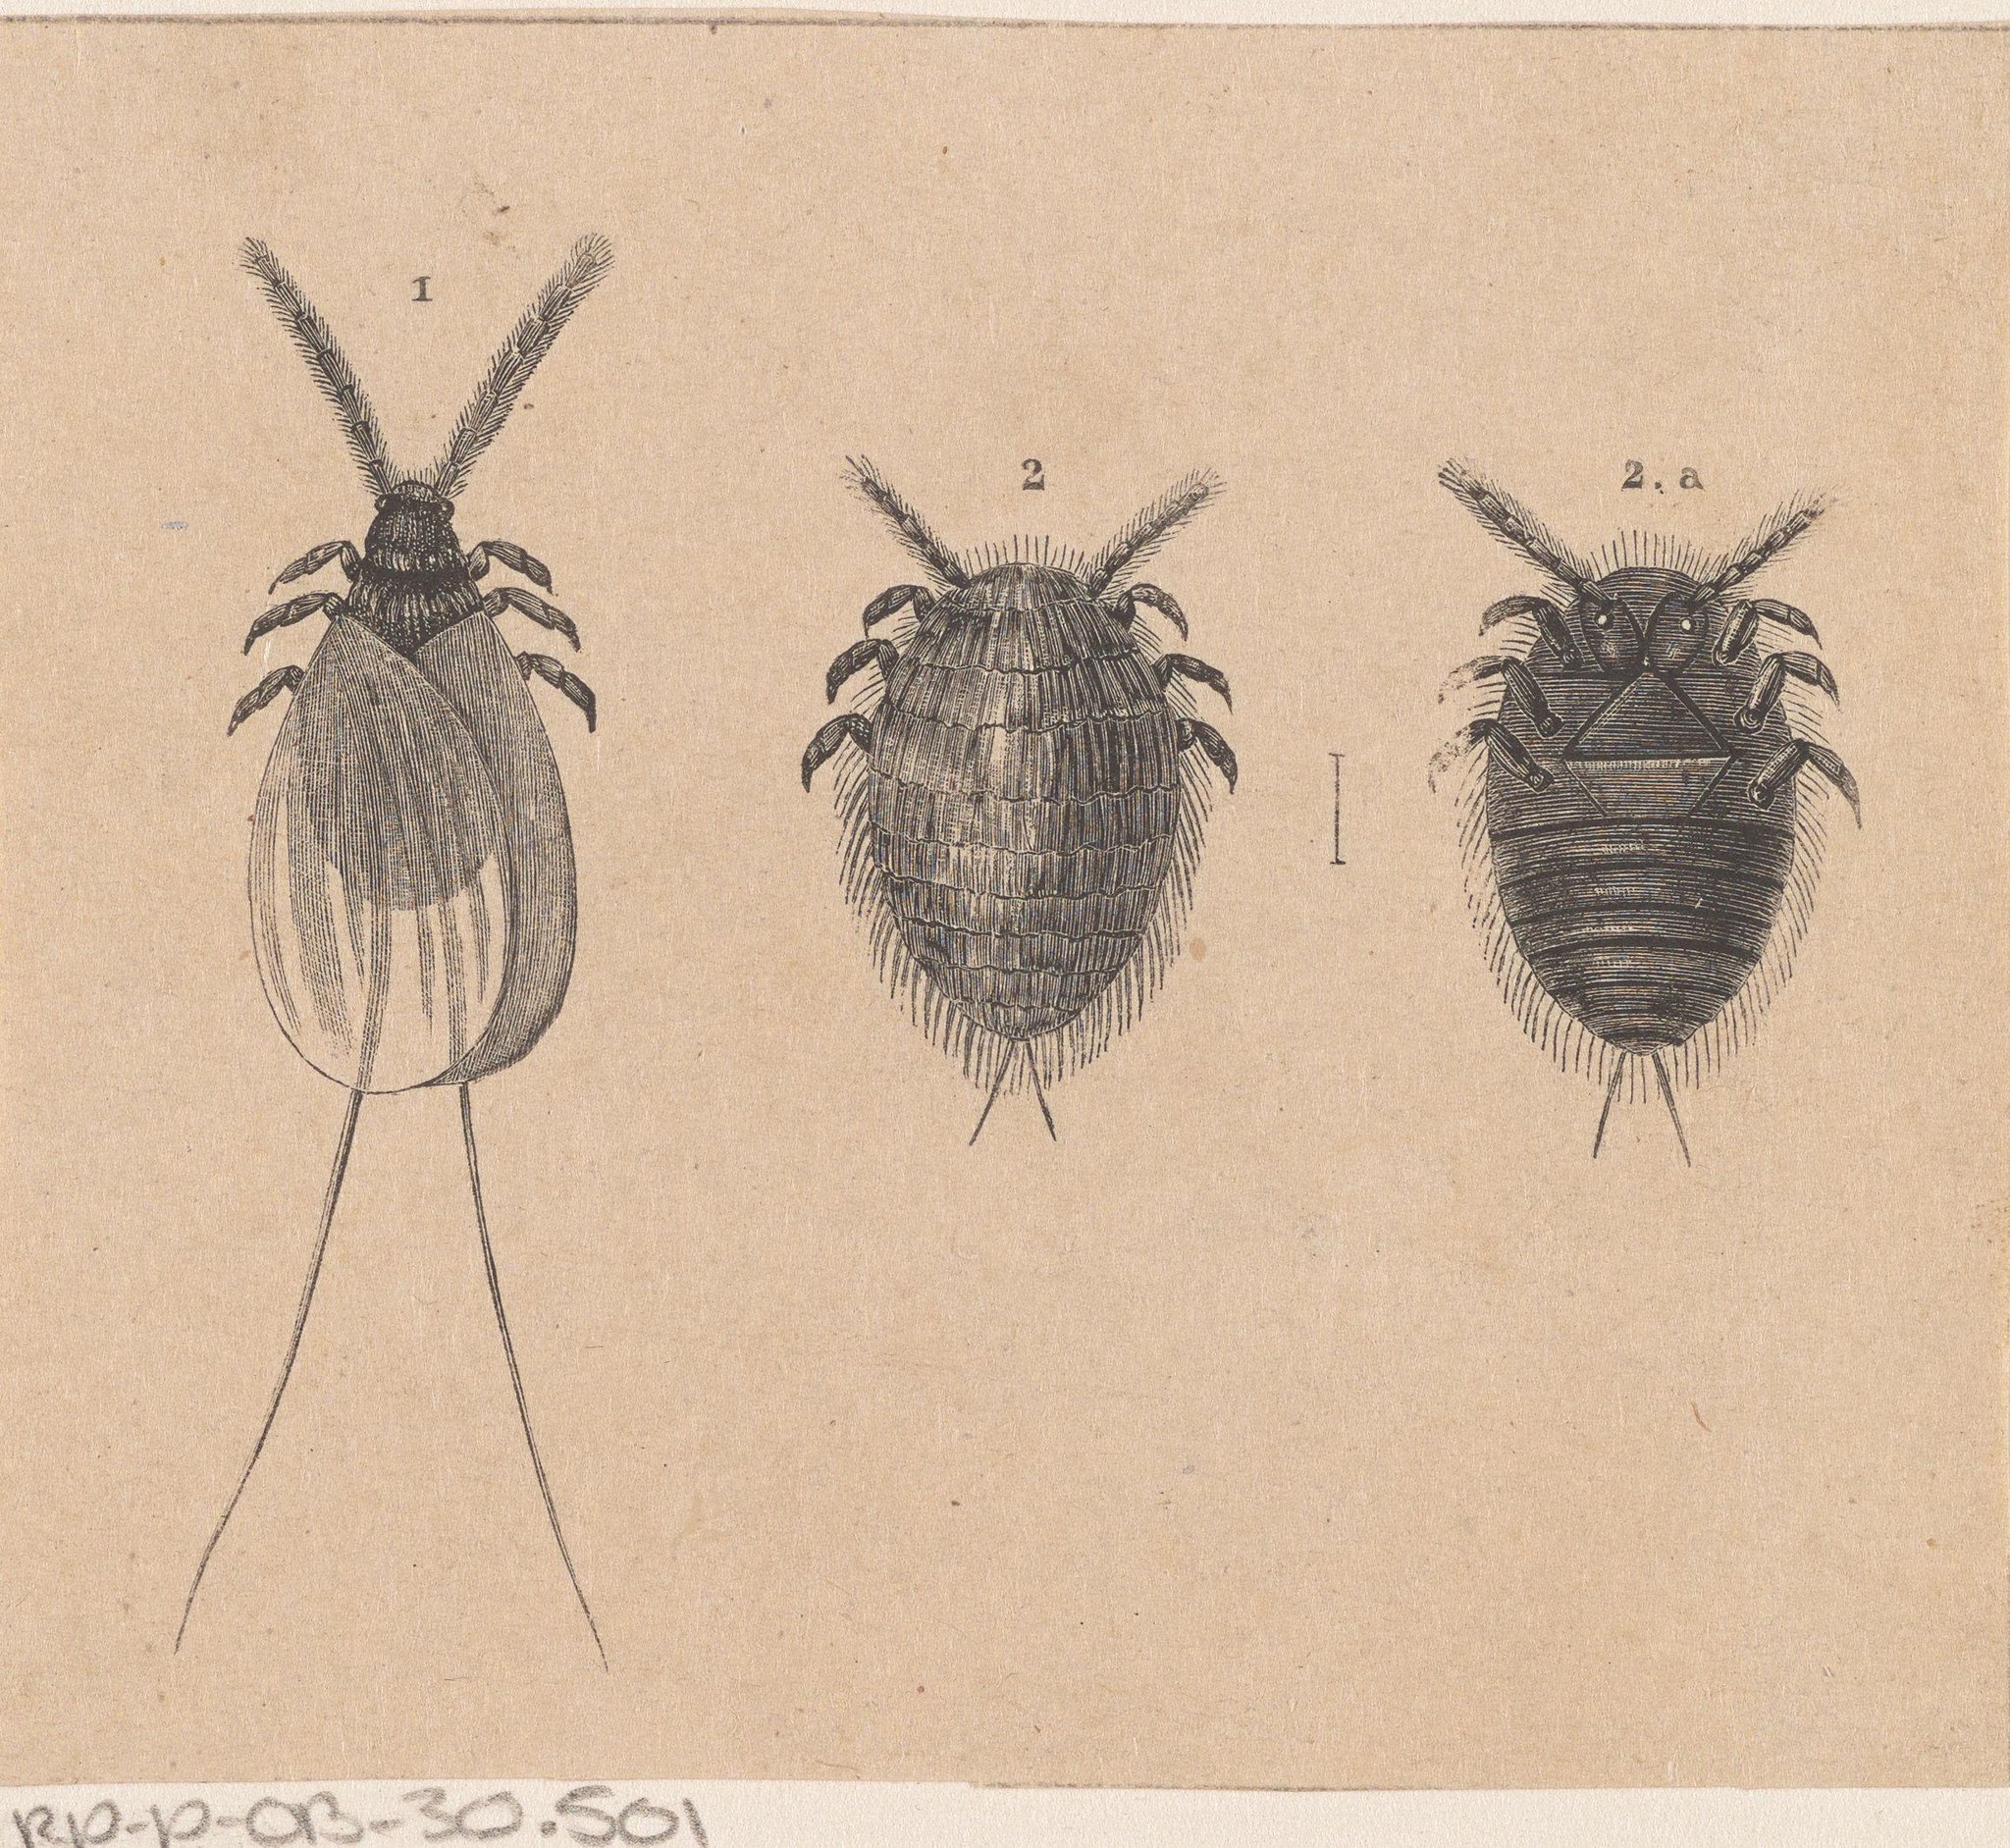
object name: print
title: Drie instecten (mogelijk bedwantsen)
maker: isaac weissenbruch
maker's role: print maker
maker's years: 1826-1912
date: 1836-1912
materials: paper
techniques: engraving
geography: netherlands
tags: insects